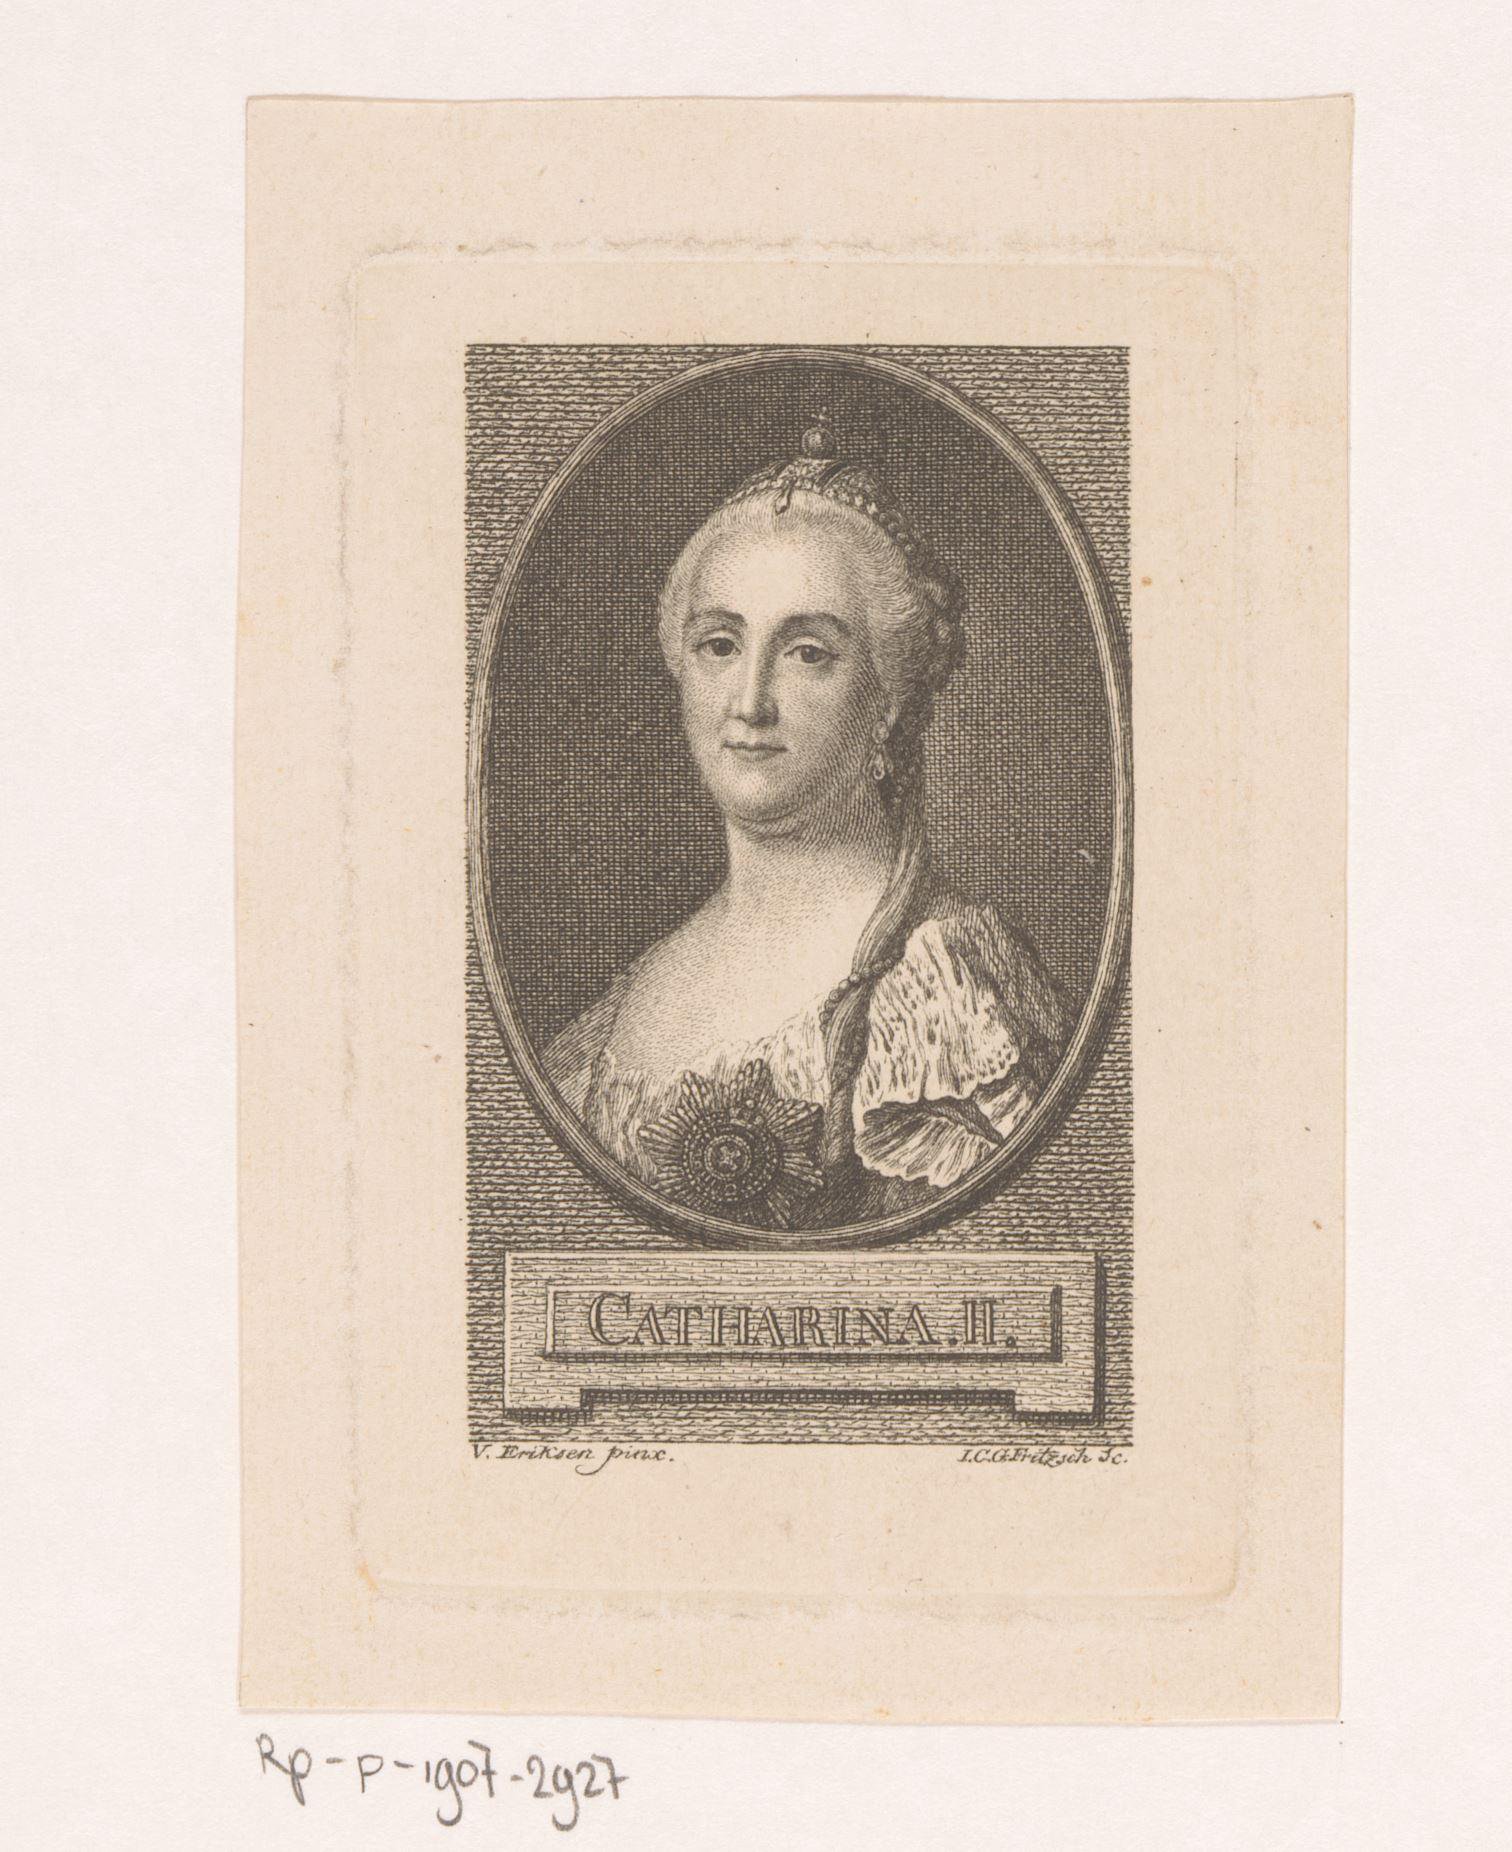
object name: print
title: Portret van Catharina de Grote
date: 1739-1803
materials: paper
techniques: engraving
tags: catharina de grote, knighthood order, historical persons - bb - woman, ruler, sovereign - bb - female ruler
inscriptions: collector's mark: Lugt 2228